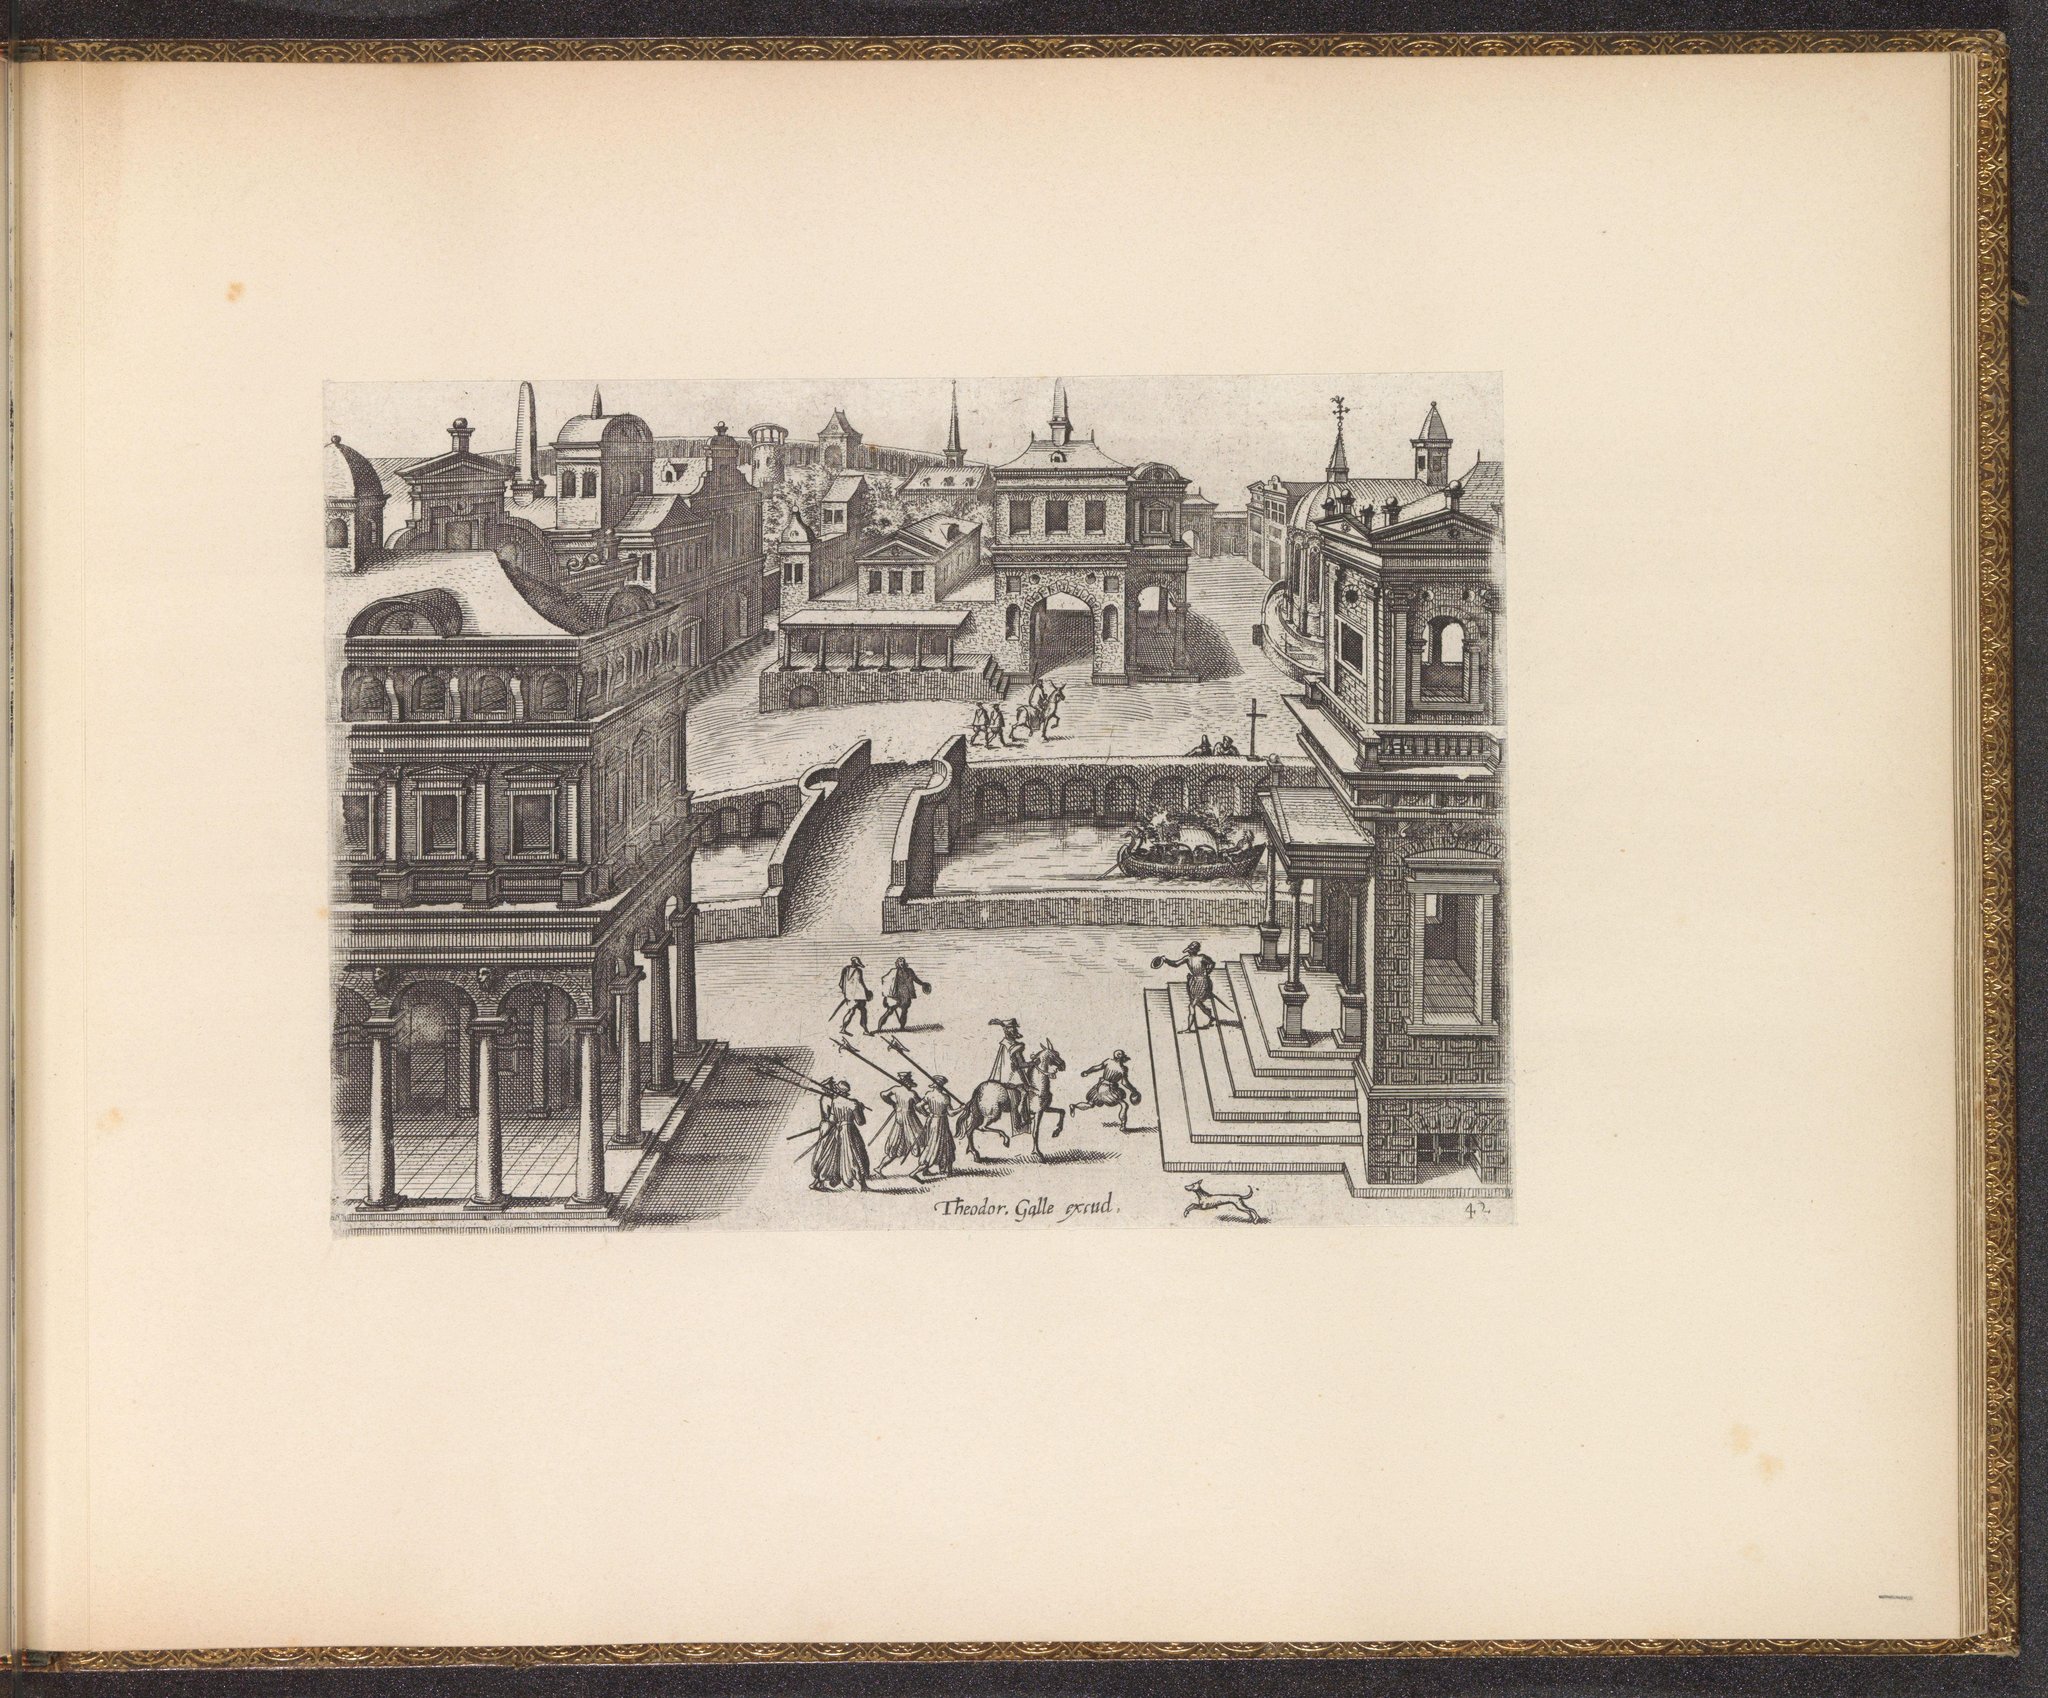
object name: ornament print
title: Architectuurperspectieven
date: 1601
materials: paper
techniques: etching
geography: antwerp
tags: city-view in general; 'veduta', canal, street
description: Stadsgezicht in semi-vogelvlucht. Links en rechts op de voorgrond staan gebouwen. Daartussen rijdt een heer te paard, begeleid door hellebaardiers. Op de gracht vaart een boot. De prent maakt deel uit van een album.